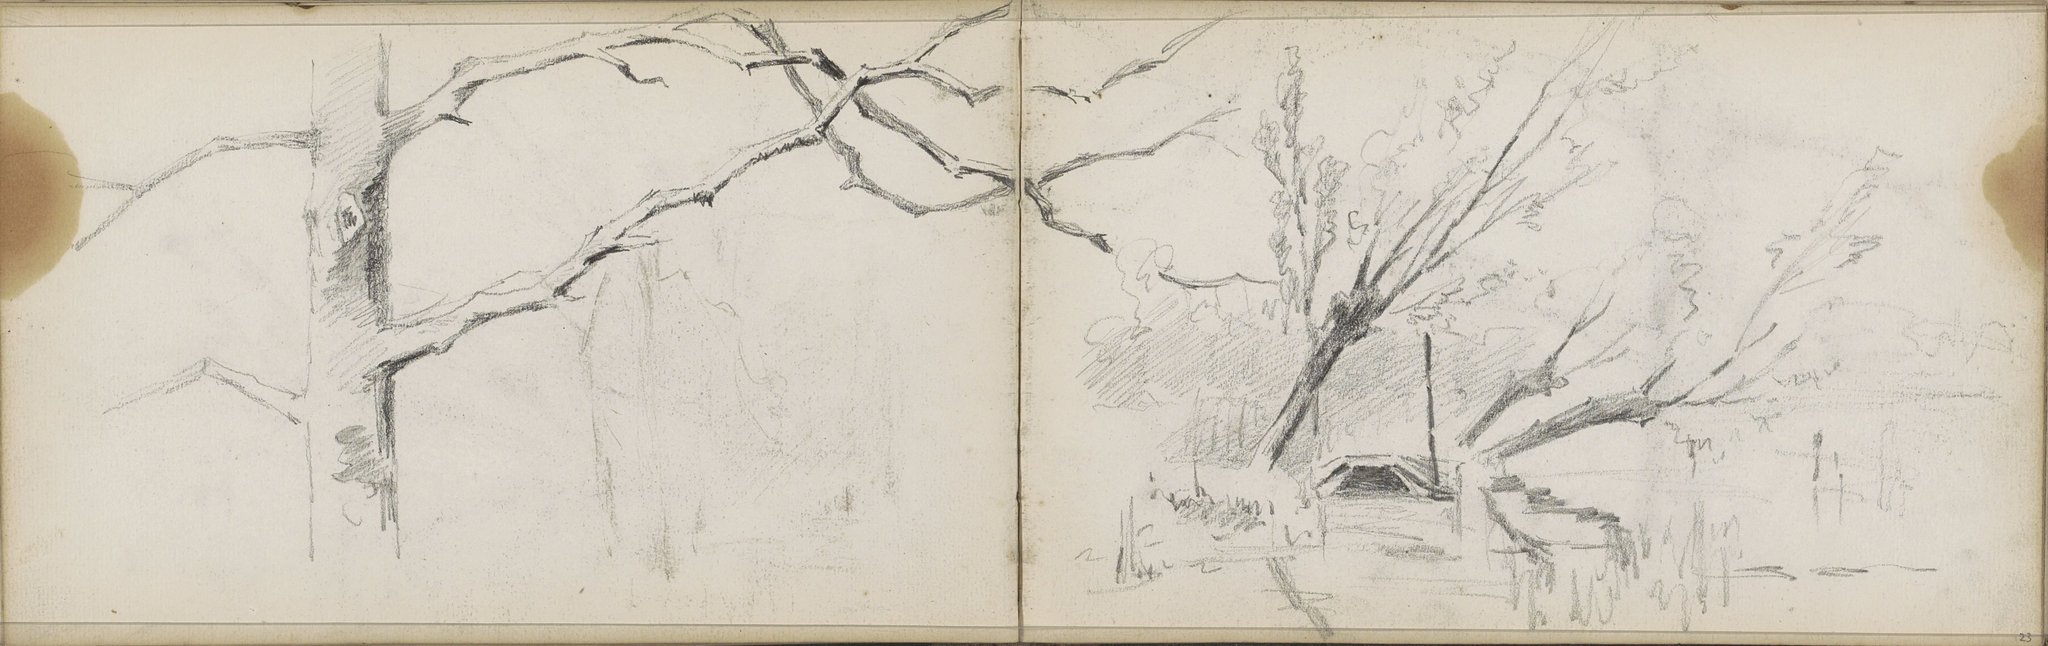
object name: sketchbook leaf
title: Overhellende bomen langs een waterkant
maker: willem cornelis rip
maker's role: draughtsman, painter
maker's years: 1856-1922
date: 1876-1877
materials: paper, pencil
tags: trees, landscapes with waters, waterscapes, seascapes (in the temperate zone)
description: Tevens een studie van een boomstam en takken. Blad 22 verso en 23 recto uit een schetsboek met 41 bladen.